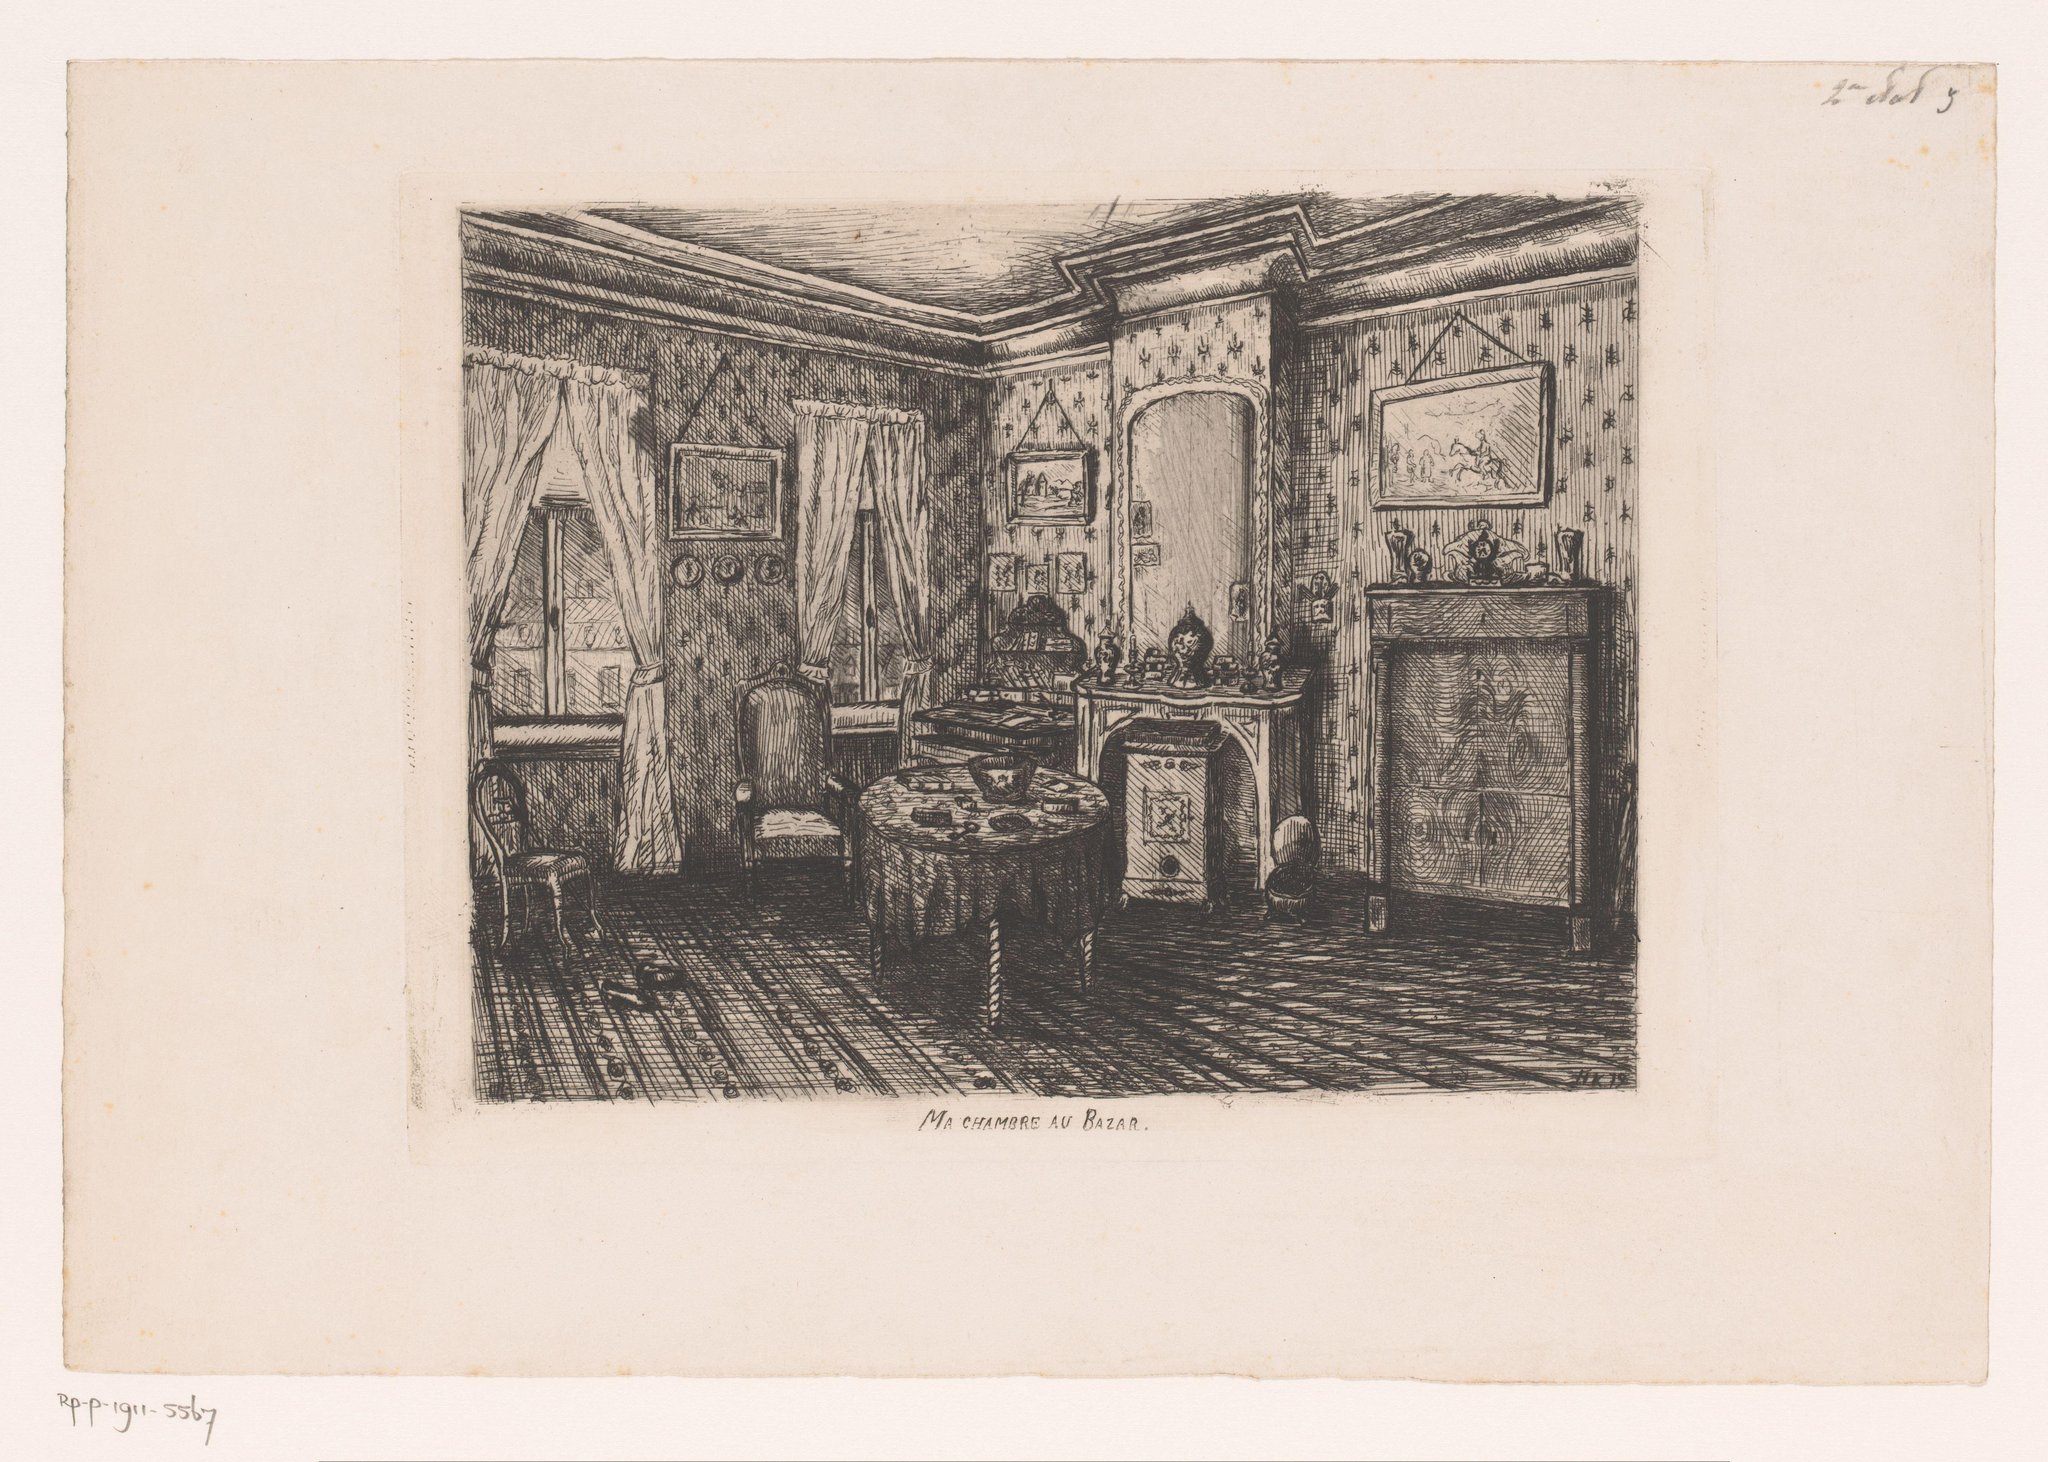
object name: print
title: Ma chambre au Bazar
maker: henri kervyn van lettenhove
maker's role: print maker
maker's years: 1856-1928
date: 1879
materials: paper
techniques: drypoint, etching, intaglio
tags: living-room, parlour, sitting-room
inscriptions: collector's mark: Lugt 2228, annotation: ‘2me etat 5’